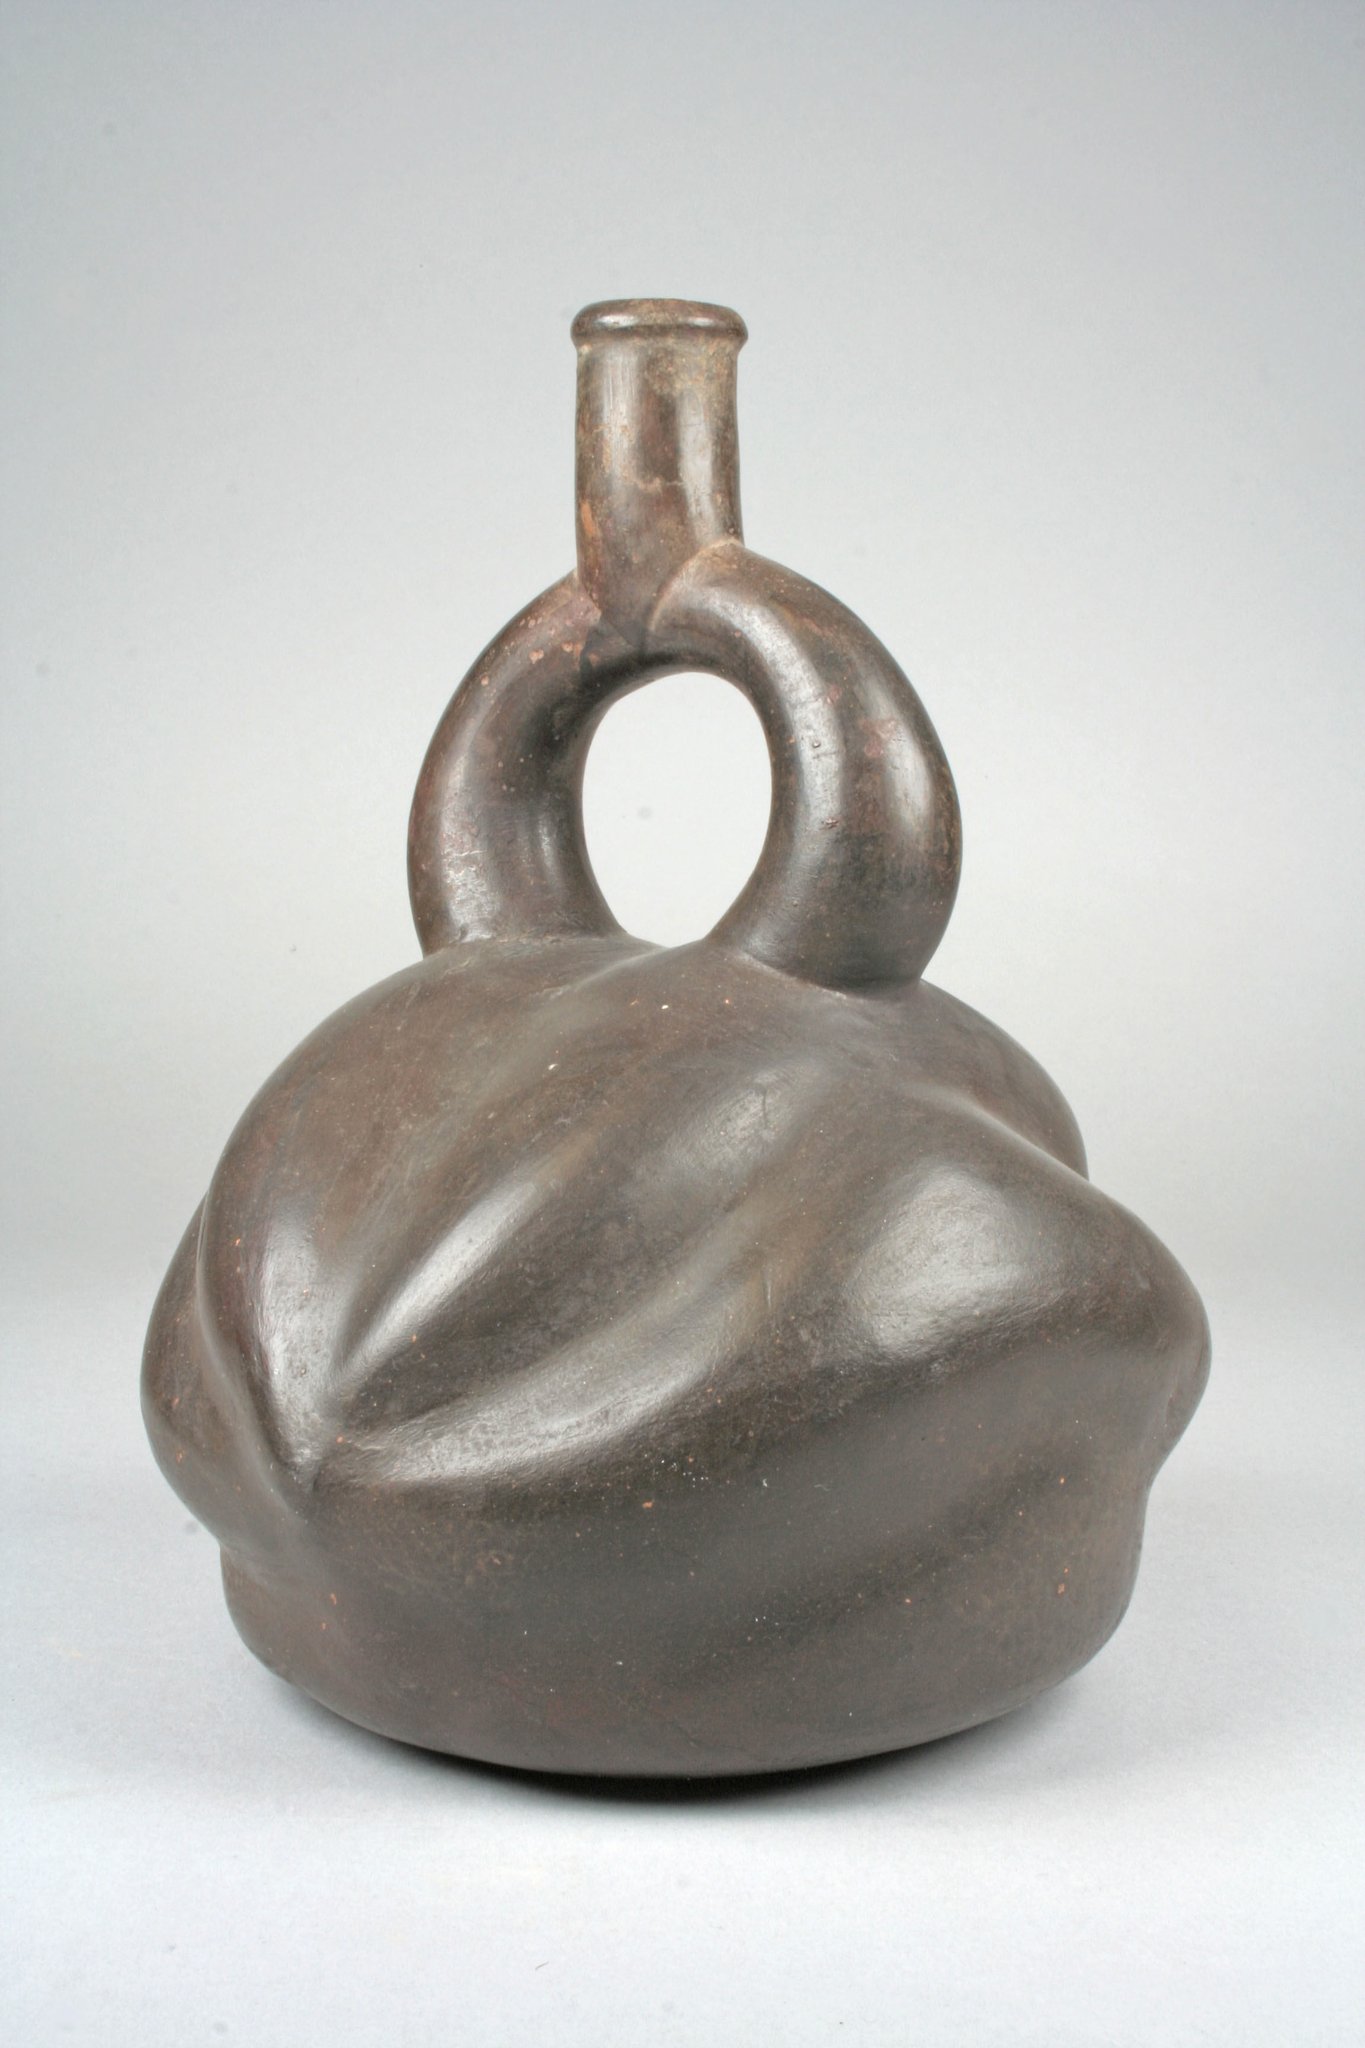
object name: bottle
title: Stirrup Spout Bottle with Fruit Form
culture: moche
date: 100 BCE-200 CE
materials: ceramic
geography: peru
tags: fruit